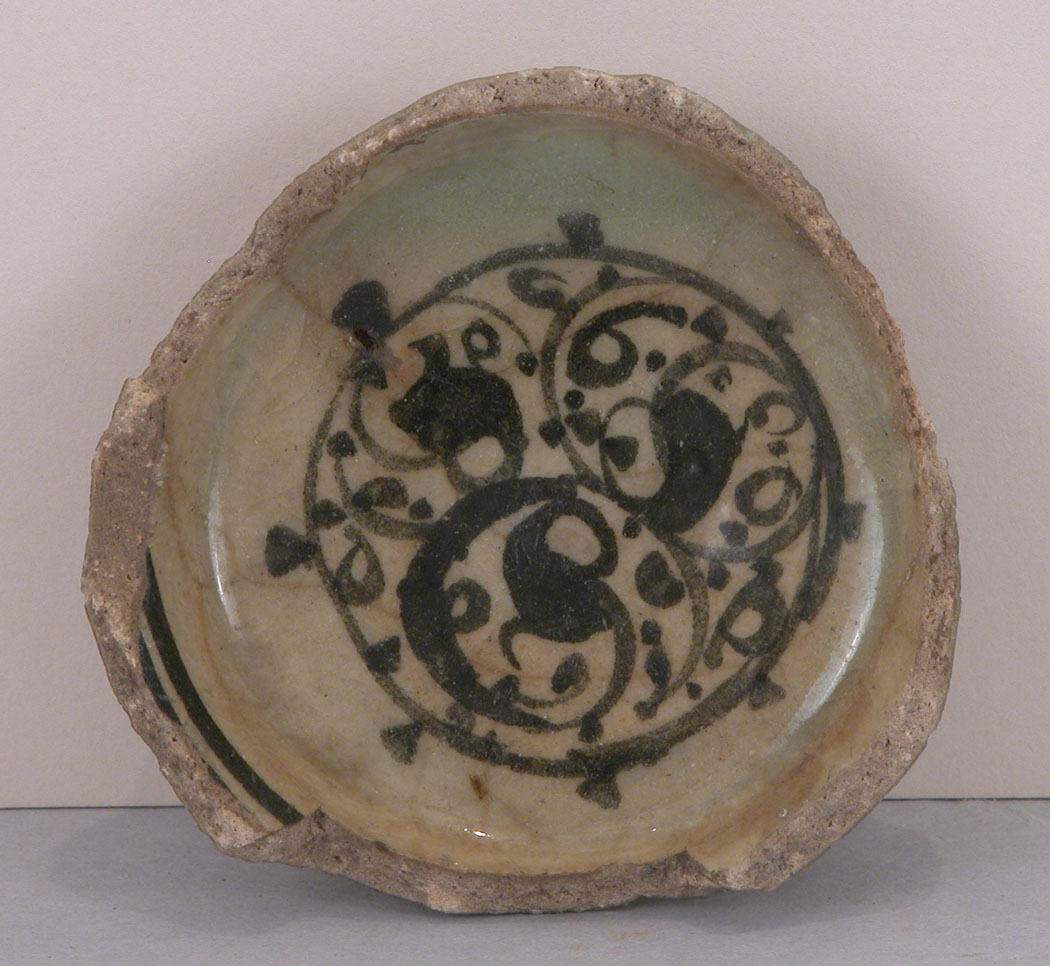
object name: fragment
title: Fragment of a Bowl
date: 1101-1300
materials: stonepaste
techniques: painting, underglaze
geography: syria